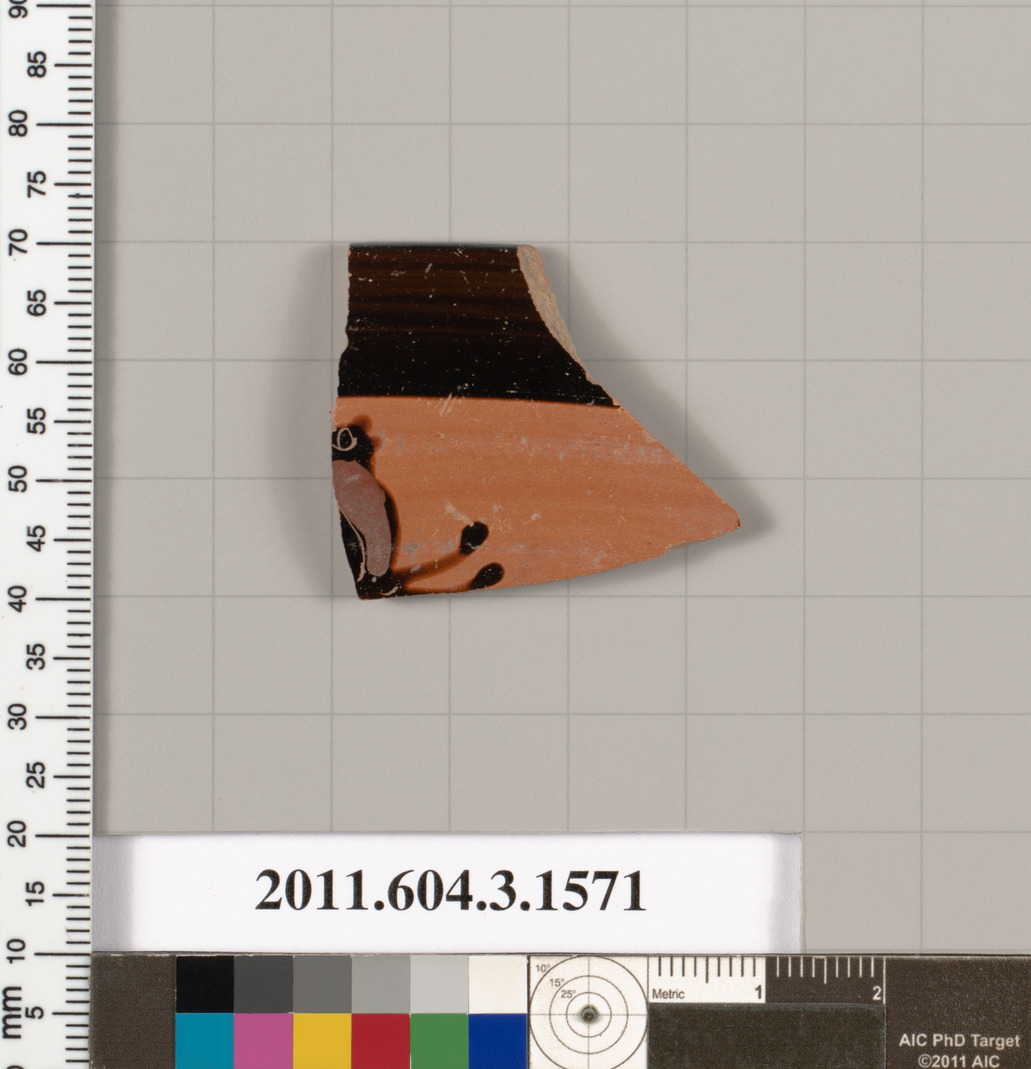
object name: kylix fragment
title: Terracotta rim fragment of a kylix: Band cup (drinking cup)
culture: greek, attic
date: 550-526 BCE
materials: terracotta